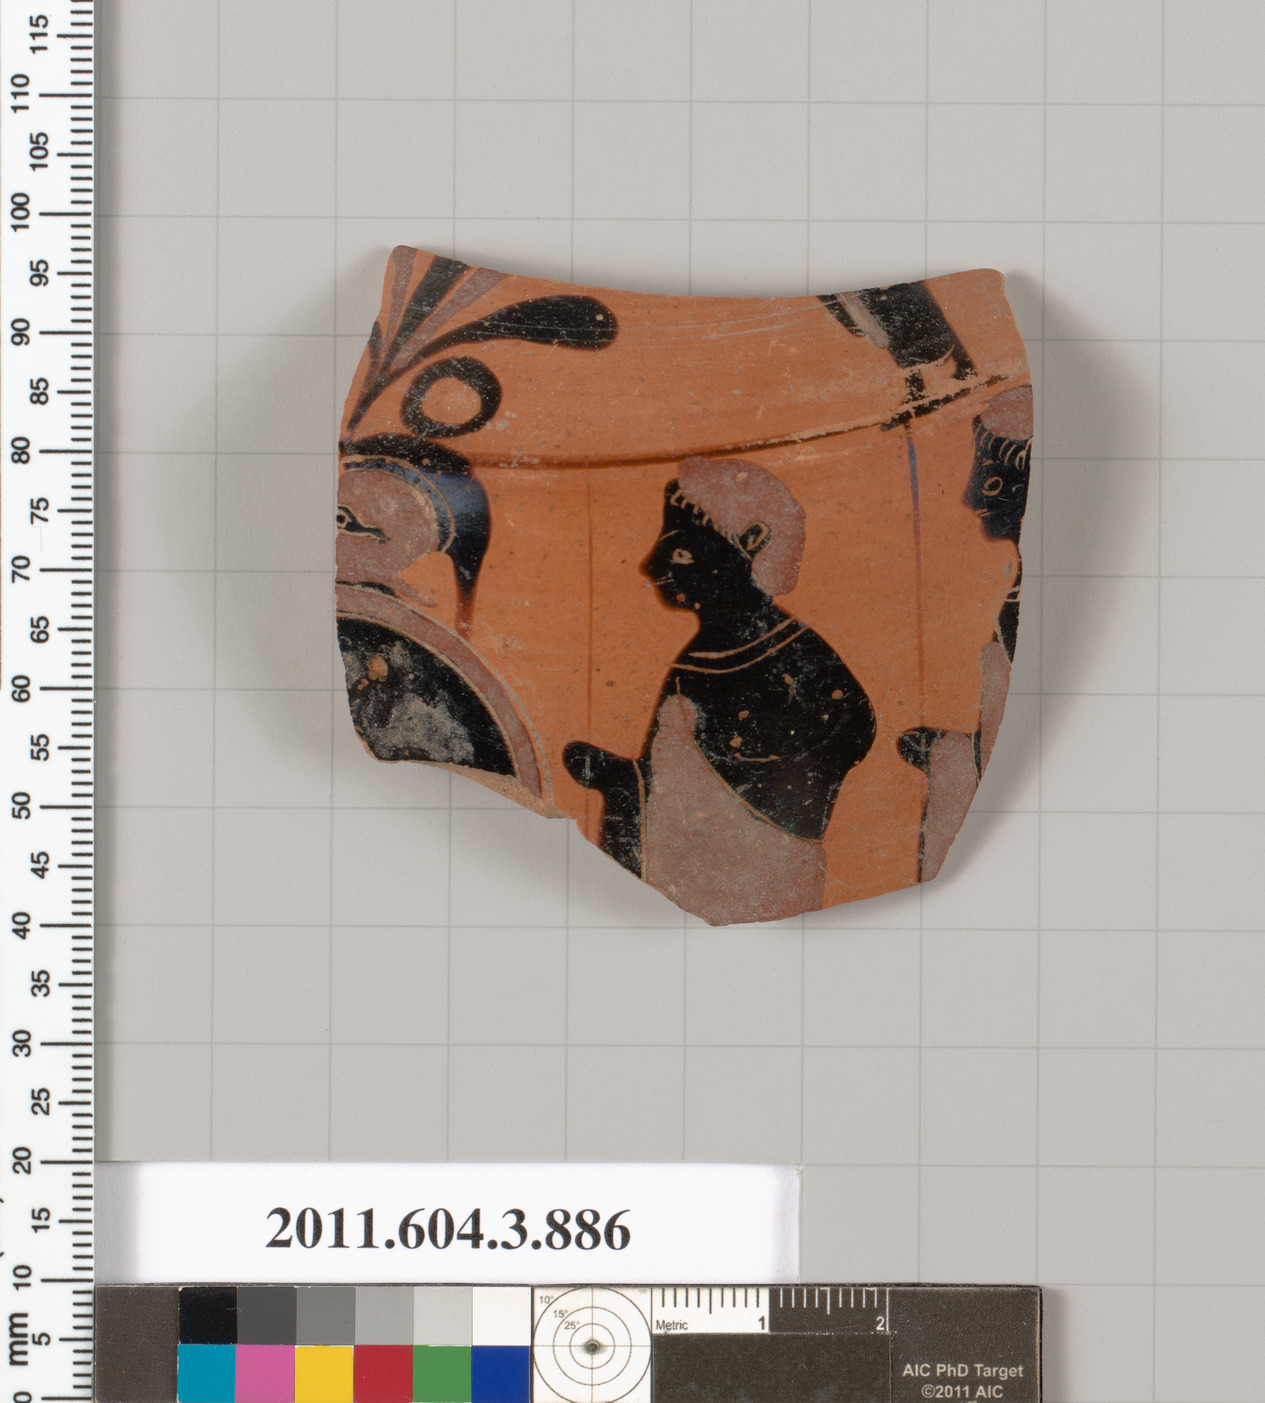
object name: lekythos fragment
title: Terracotta fragment of a lekythos (oil flask)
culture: greek, attic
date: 534-501 BCE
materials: terracotta